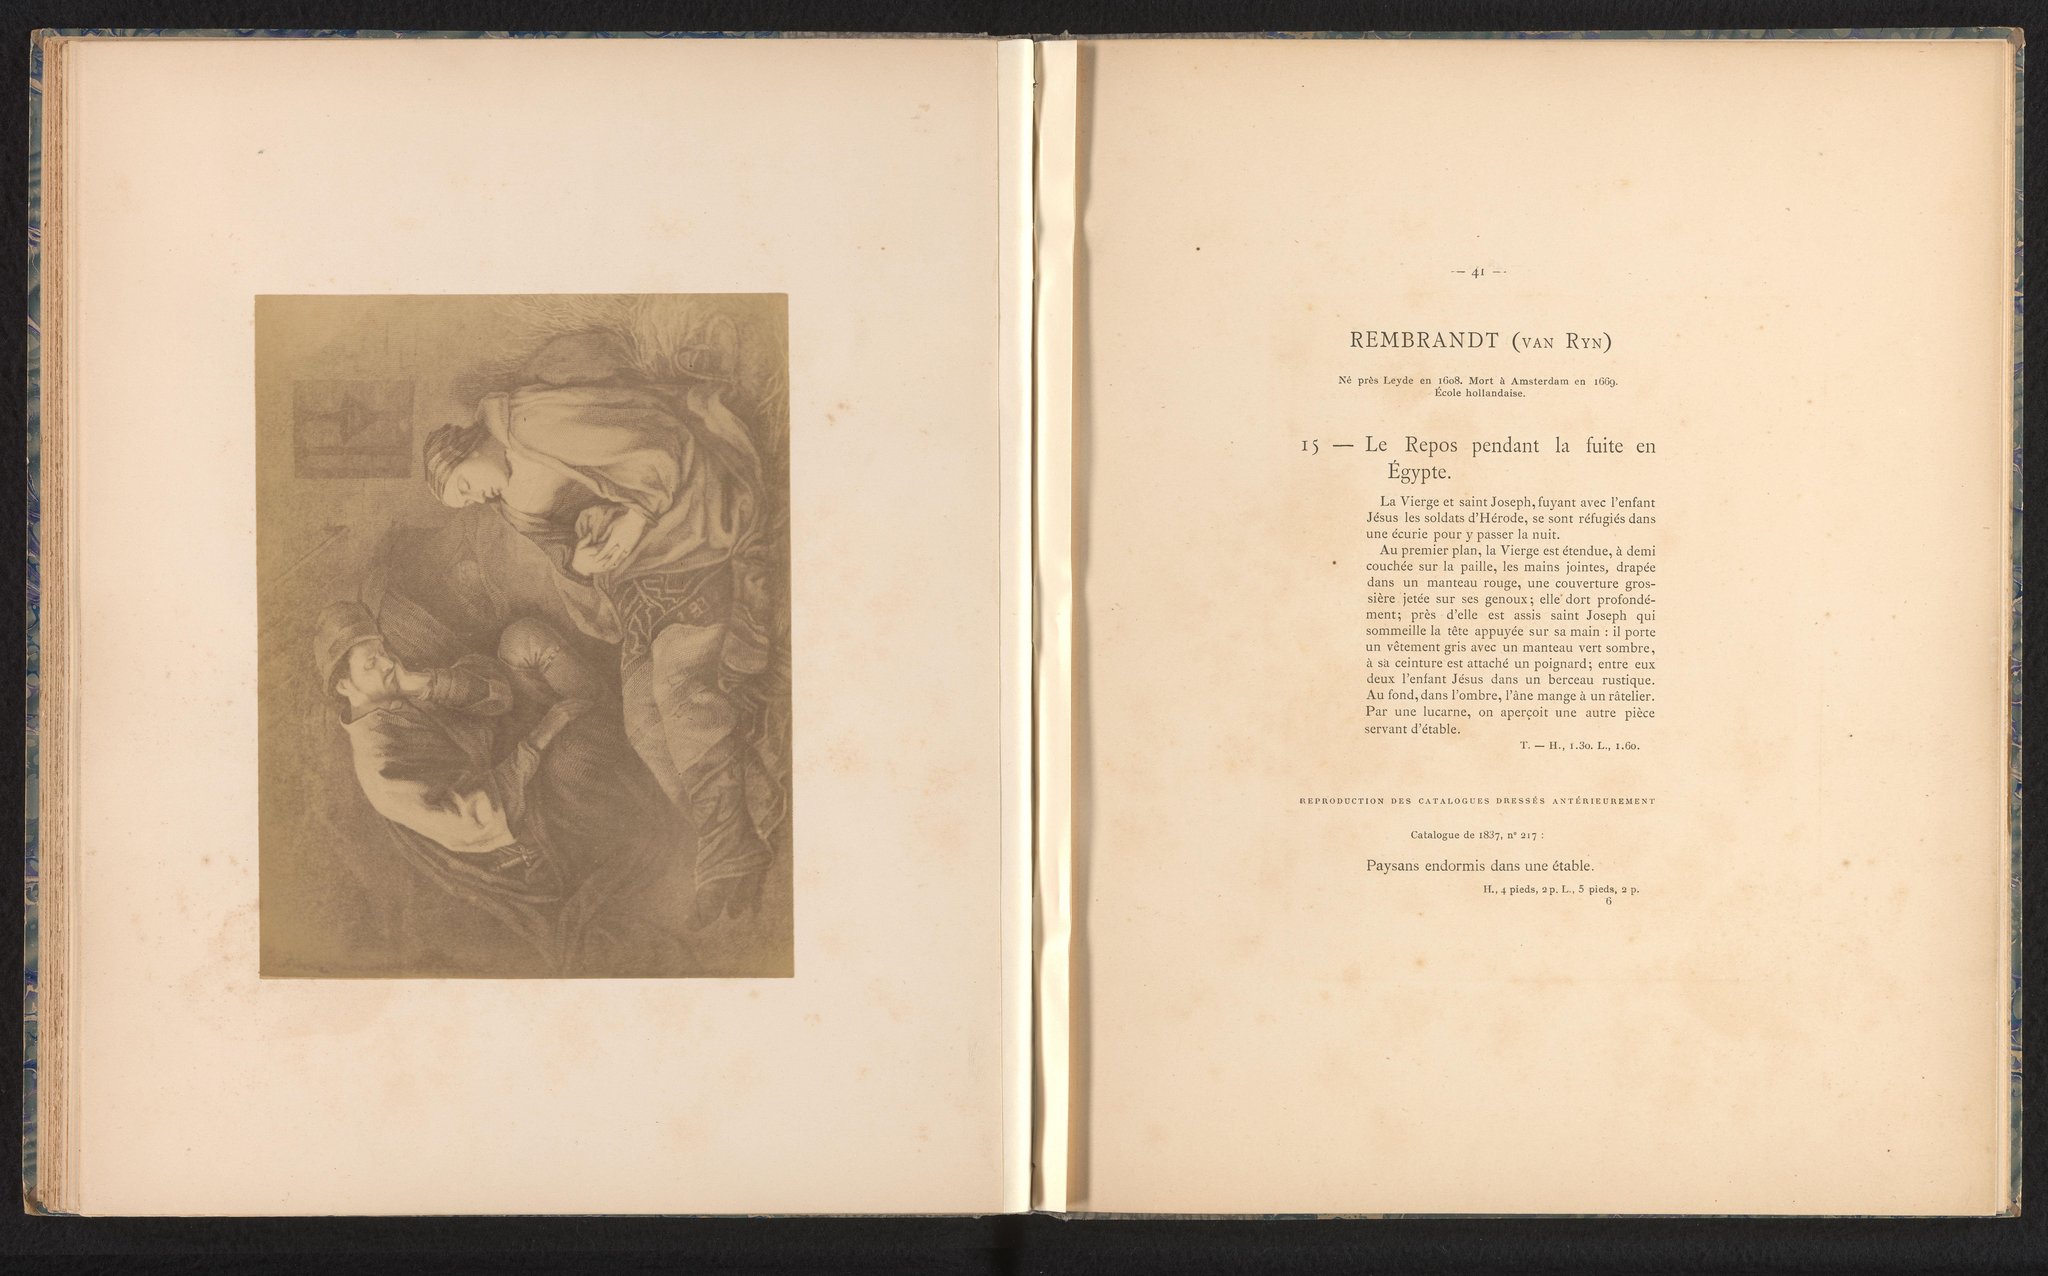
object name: photograph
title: Fotoreproductie van een gravure van de rust op de vlucht naar Egypte door Rembrandt van Rijn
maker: Anonymous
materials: paper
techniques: albumen print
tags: rest on the flight into egypt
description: Foto op de 76e ongenummerde pagina na titelpagina.